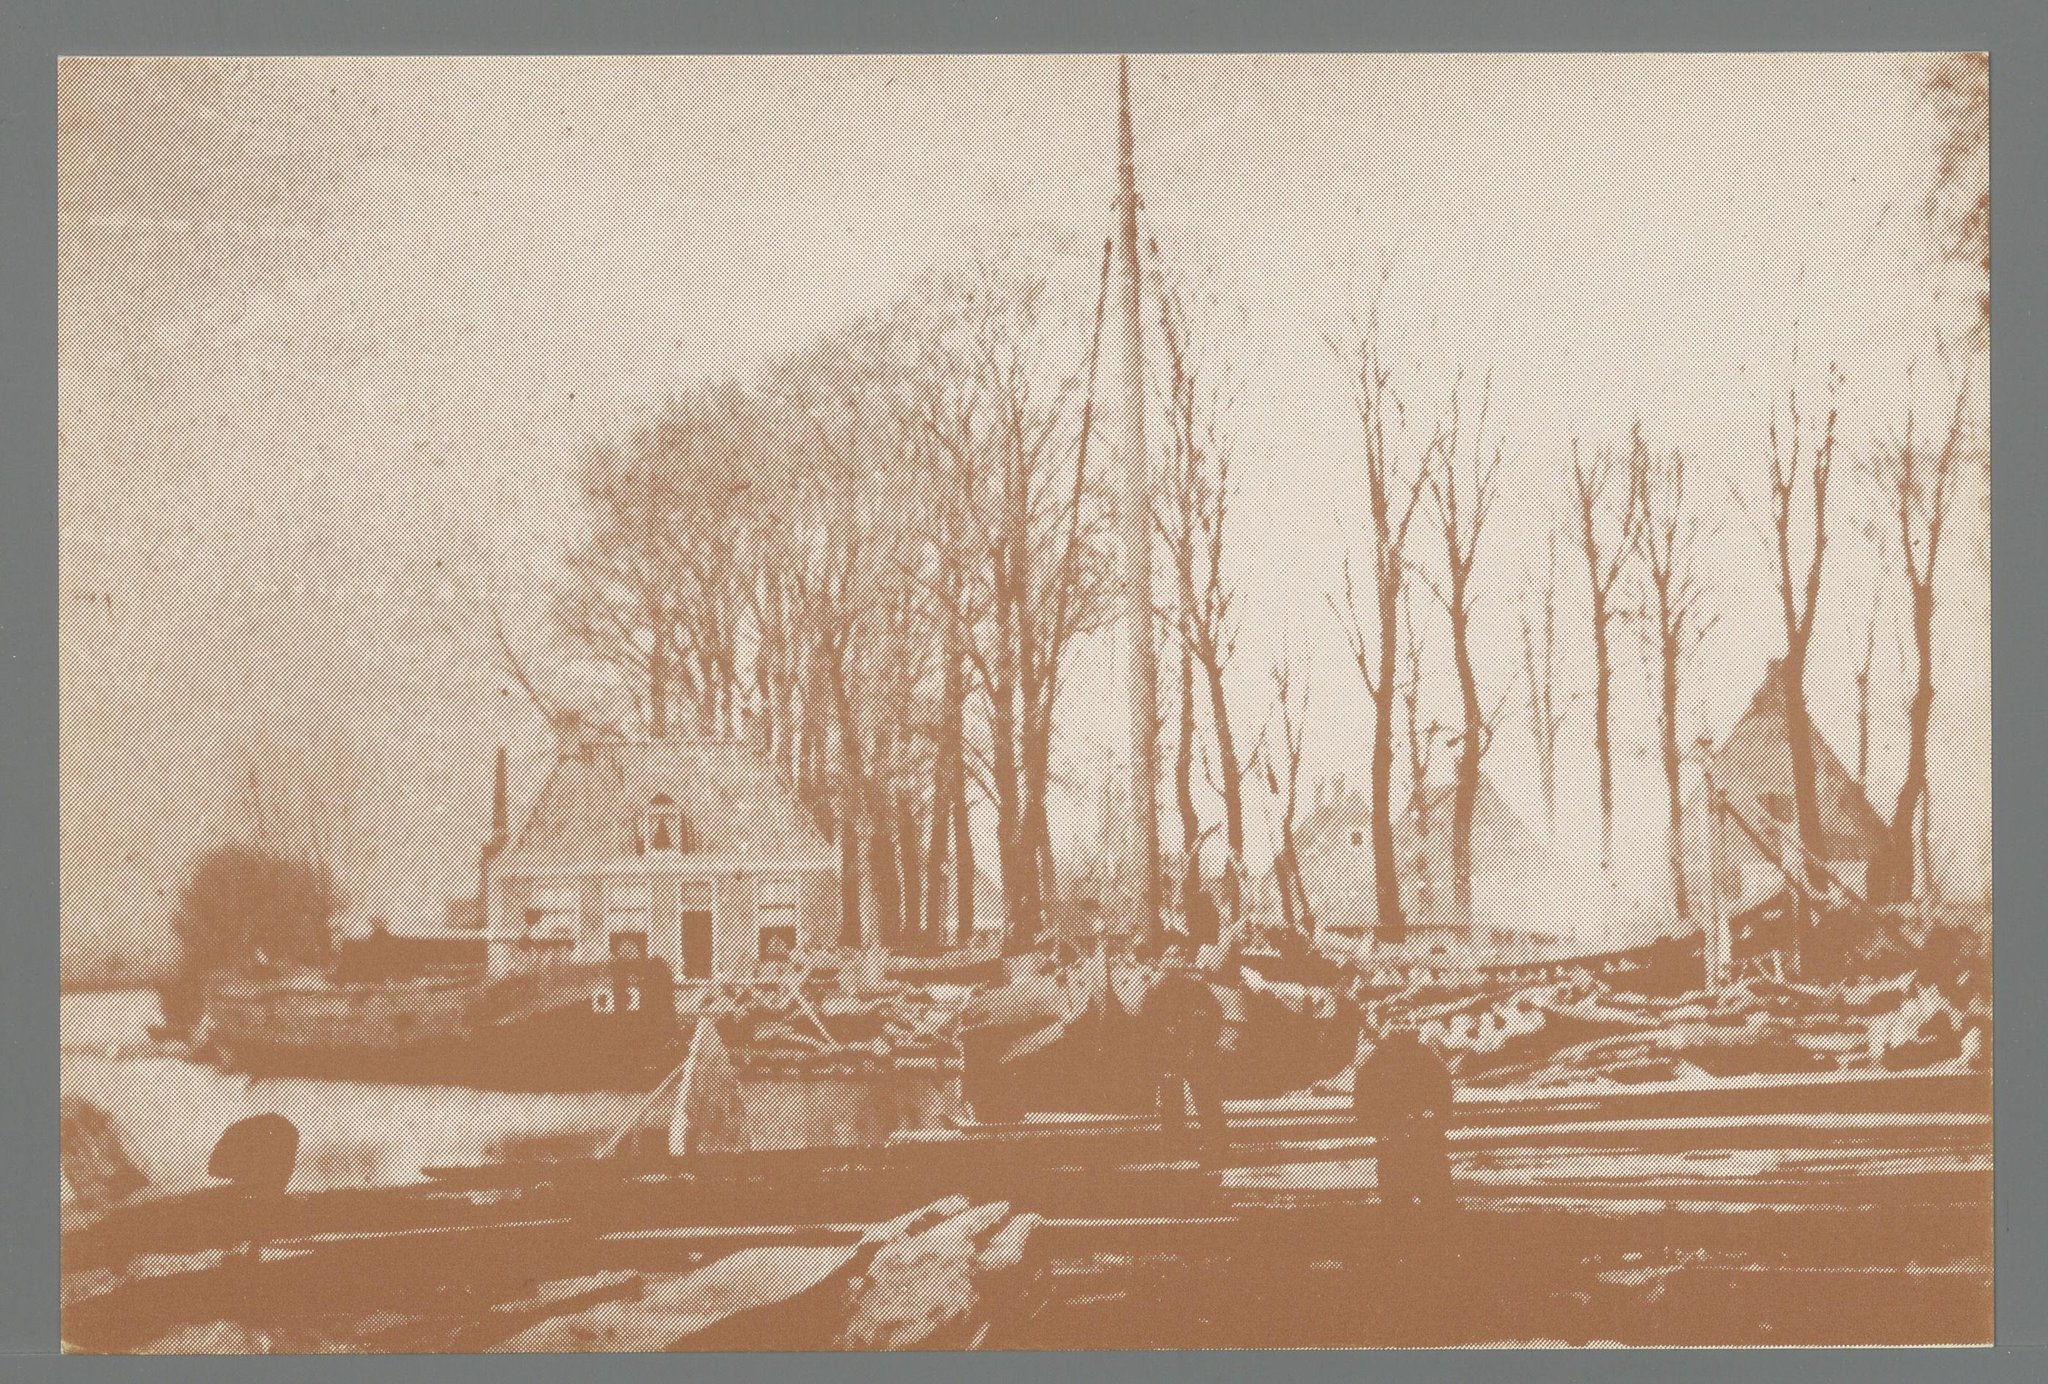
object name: photomechanical print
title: Scheepswerf aan de Dedemsvaart. Ca. 1915 (Hasselt)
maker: Anonymous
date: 1958-2021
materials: cardboard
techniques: autotype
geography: hasselt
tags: sailing-ship, sailing-boat, shipyard, shipdock